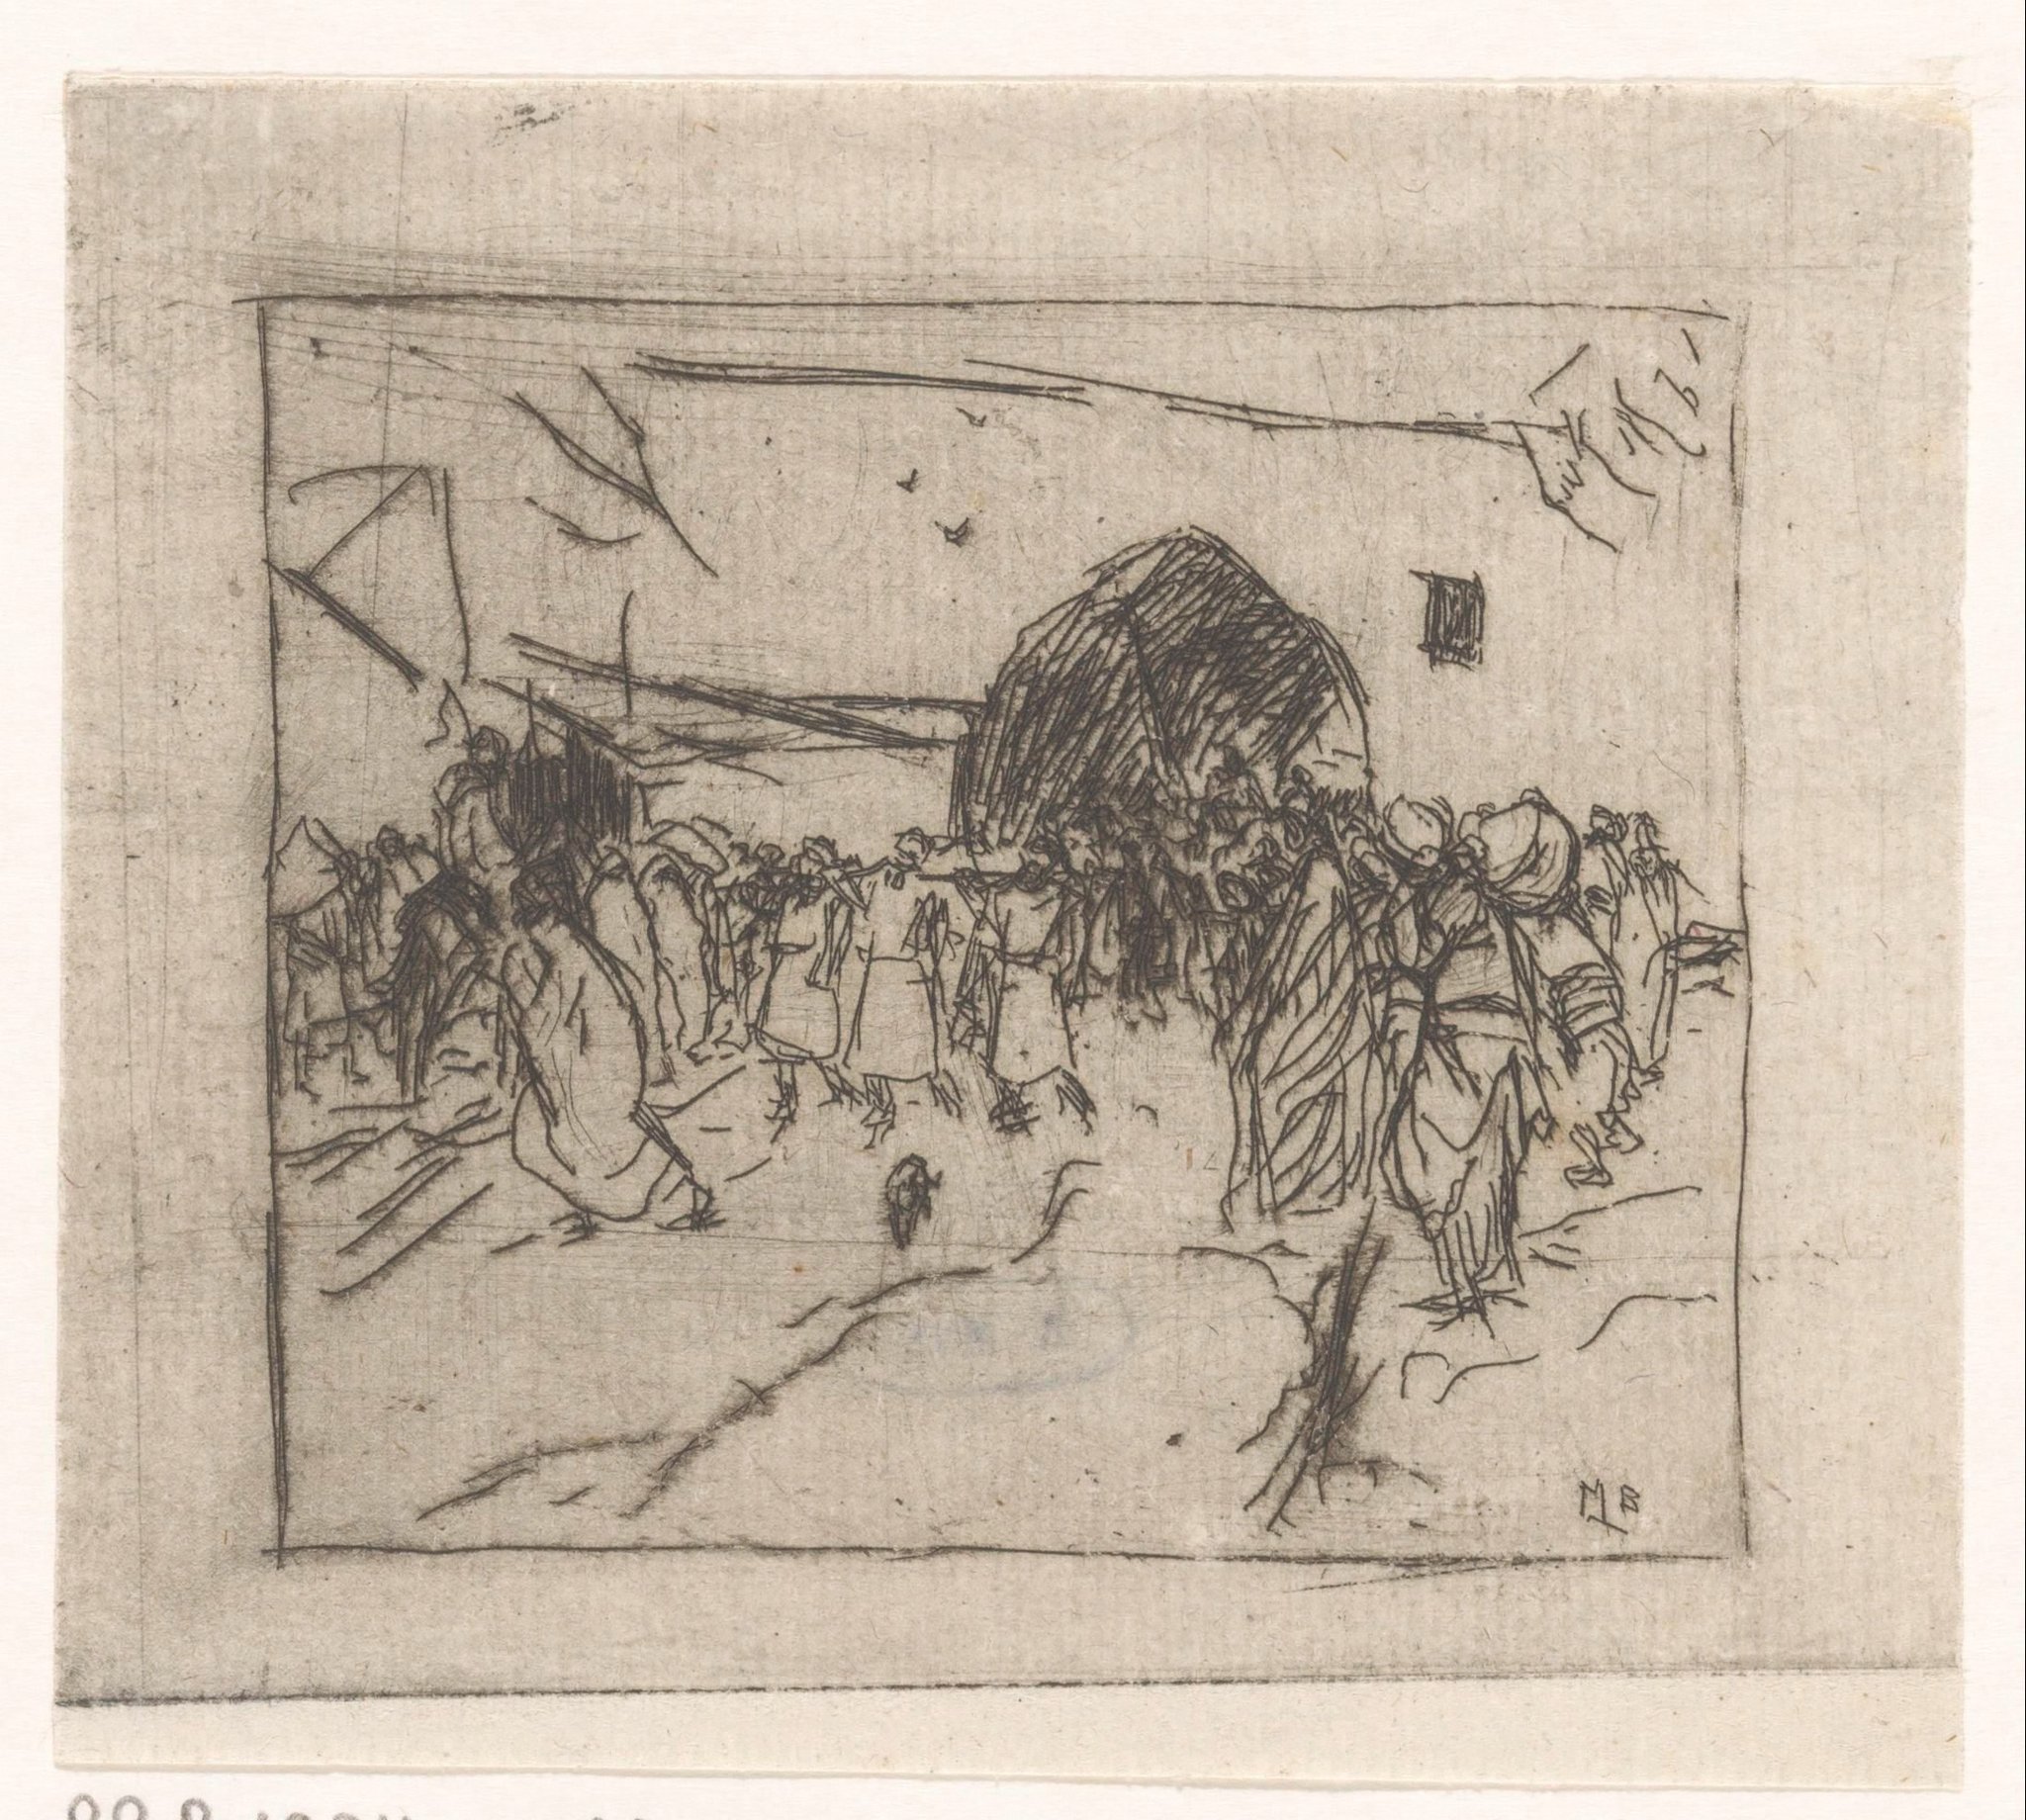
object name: print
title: Poort in Constantinopel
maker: marius bauer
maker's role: draughtsman, print maker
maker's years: 1867-1932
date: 1889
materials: paper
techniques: etching, intaglio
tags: city-gate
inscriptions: collector's mark: Lugt 2228